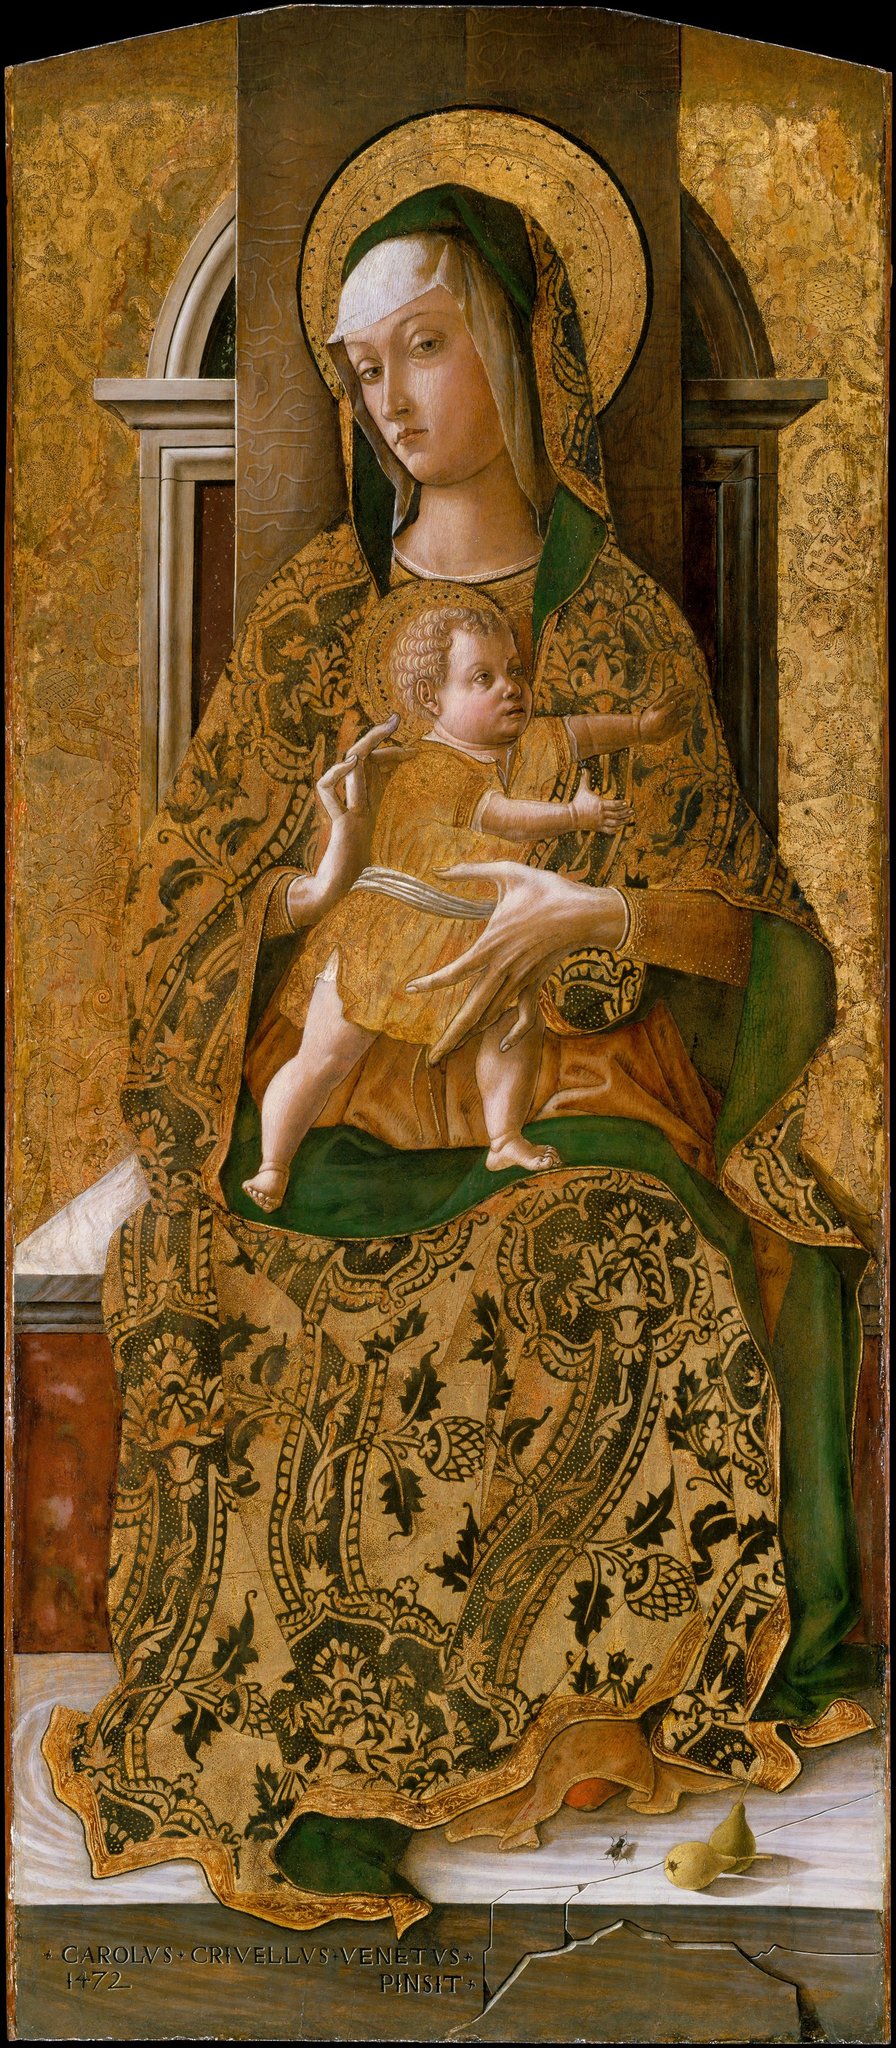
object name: painting, part of an altarpiece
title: Madonna and Child Enthroned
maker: carlo crivelli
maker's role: artist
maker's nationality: italian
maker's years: 1457-1495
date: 1472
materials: gold leaf, paint, wood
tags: madonna and child